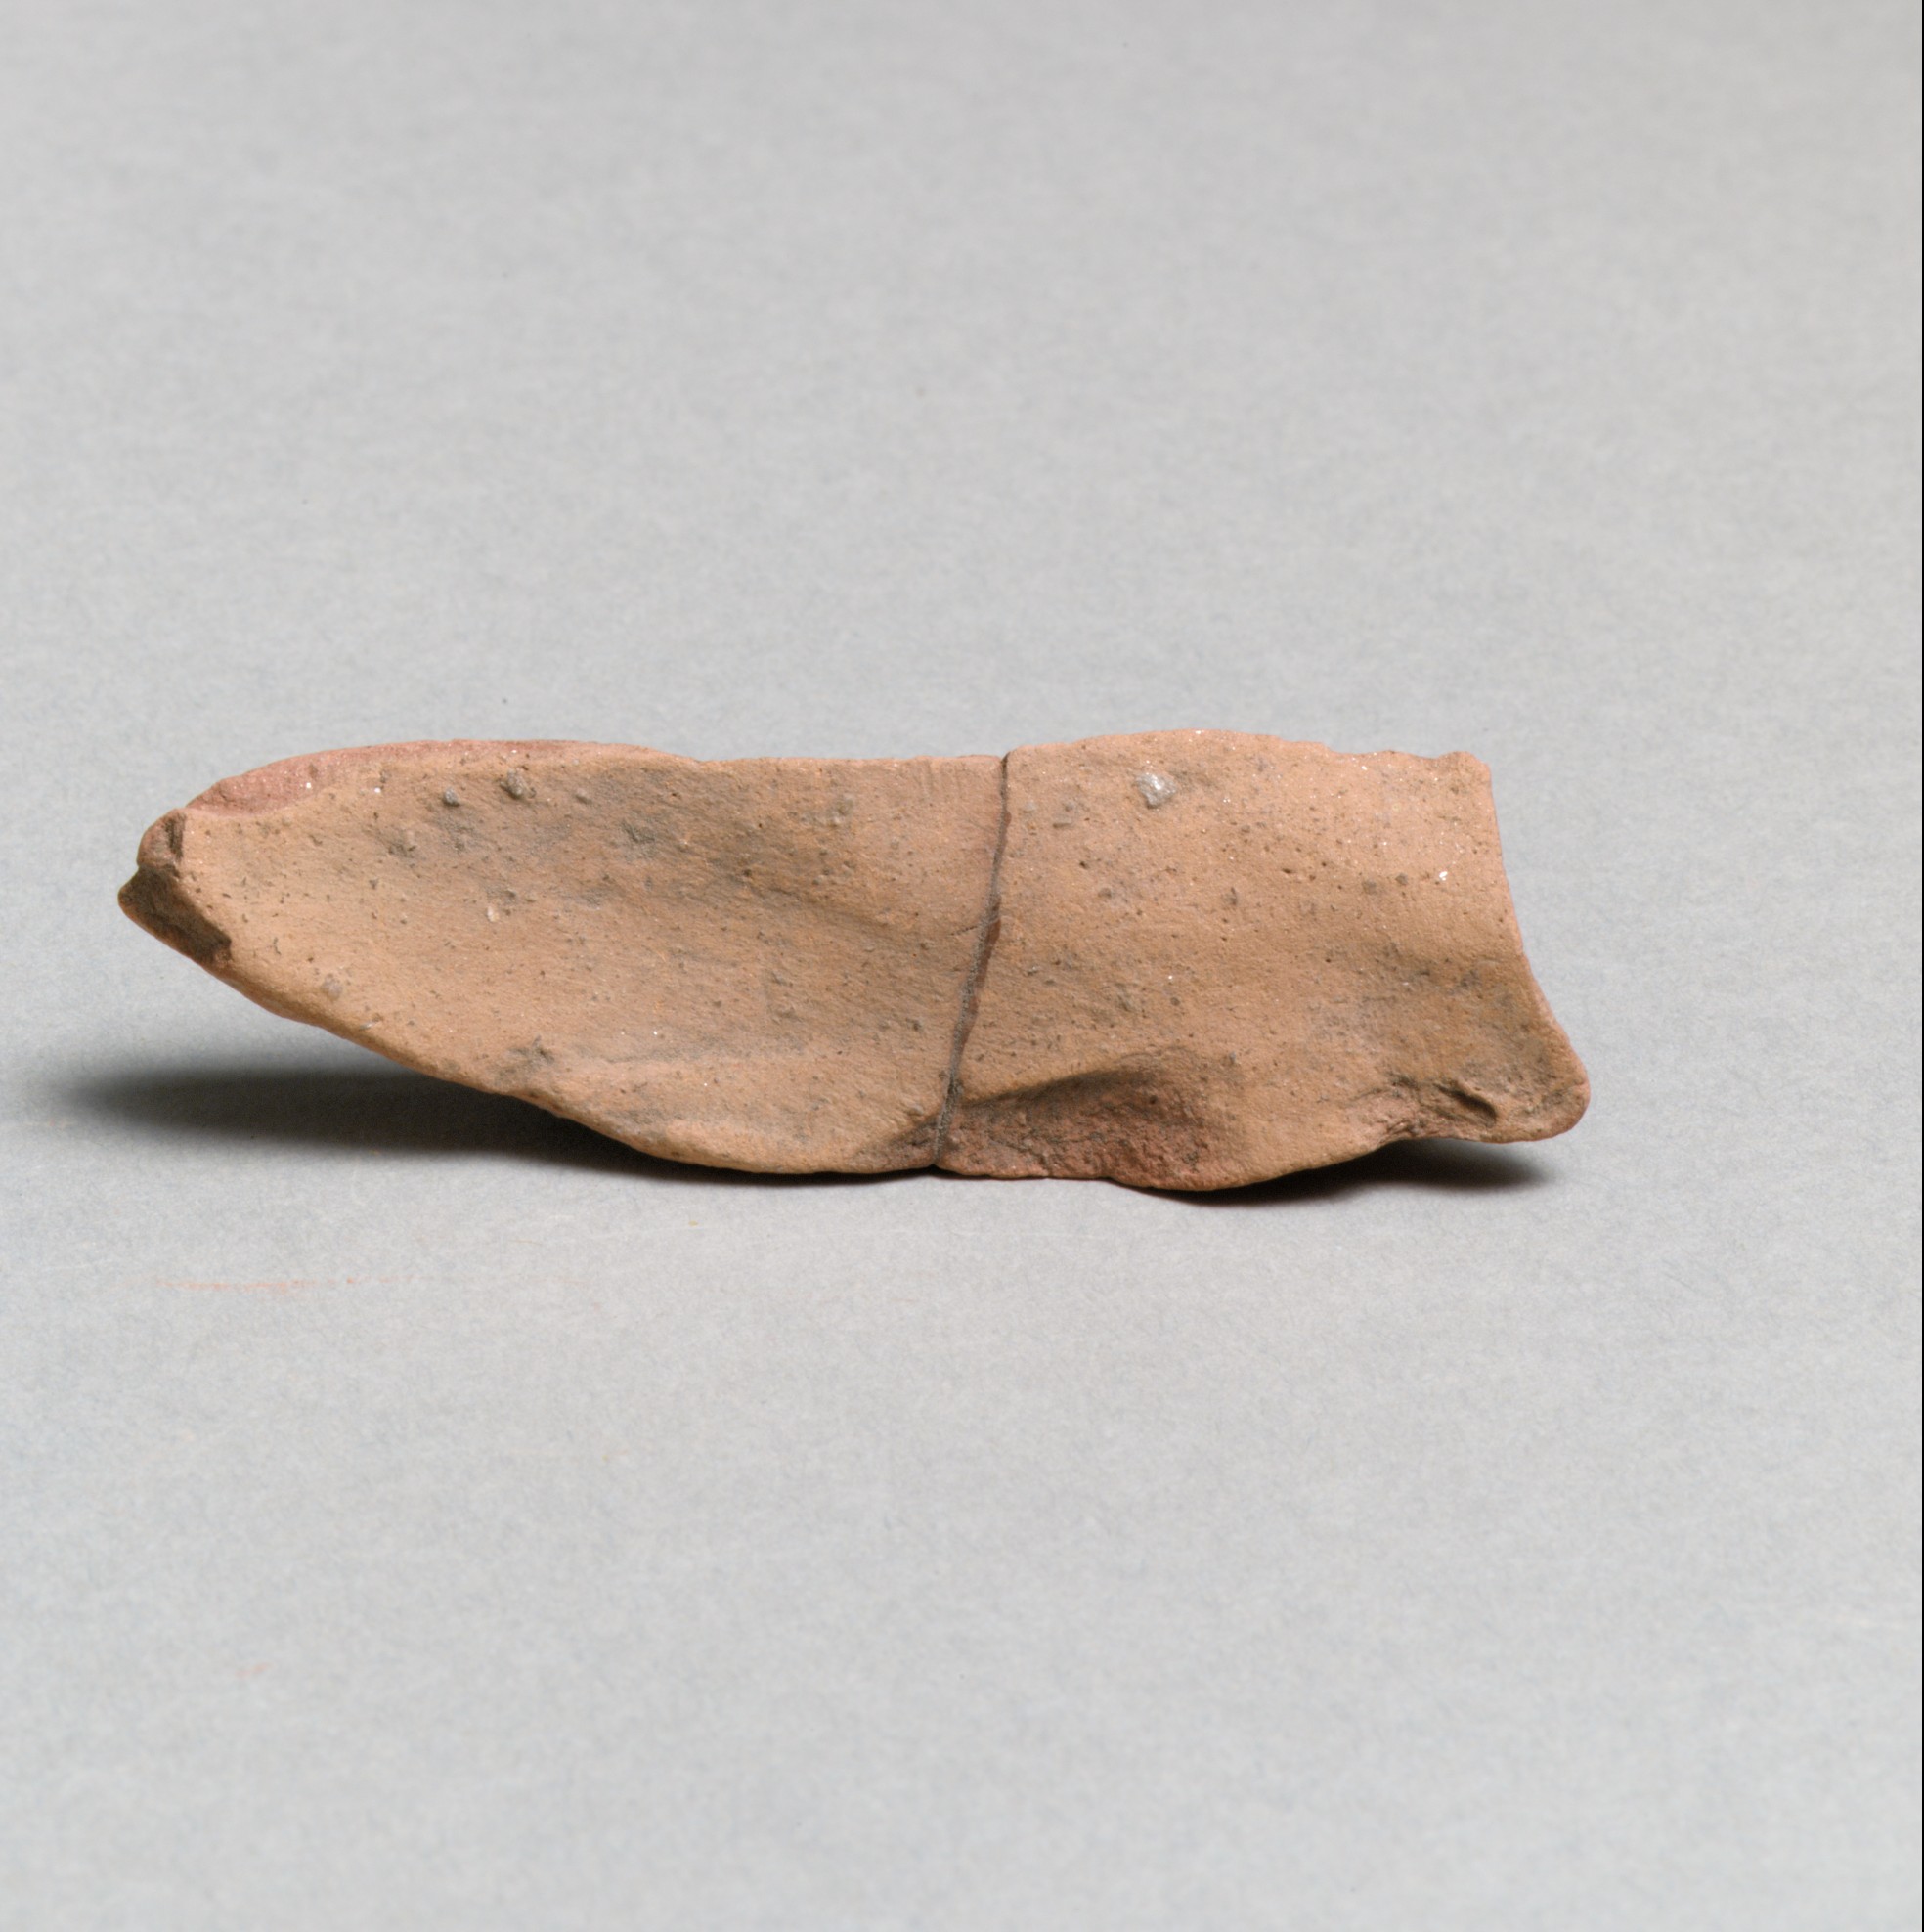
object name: vase fragment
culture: greek, lydian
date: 7000-30 BCE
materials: terracotta